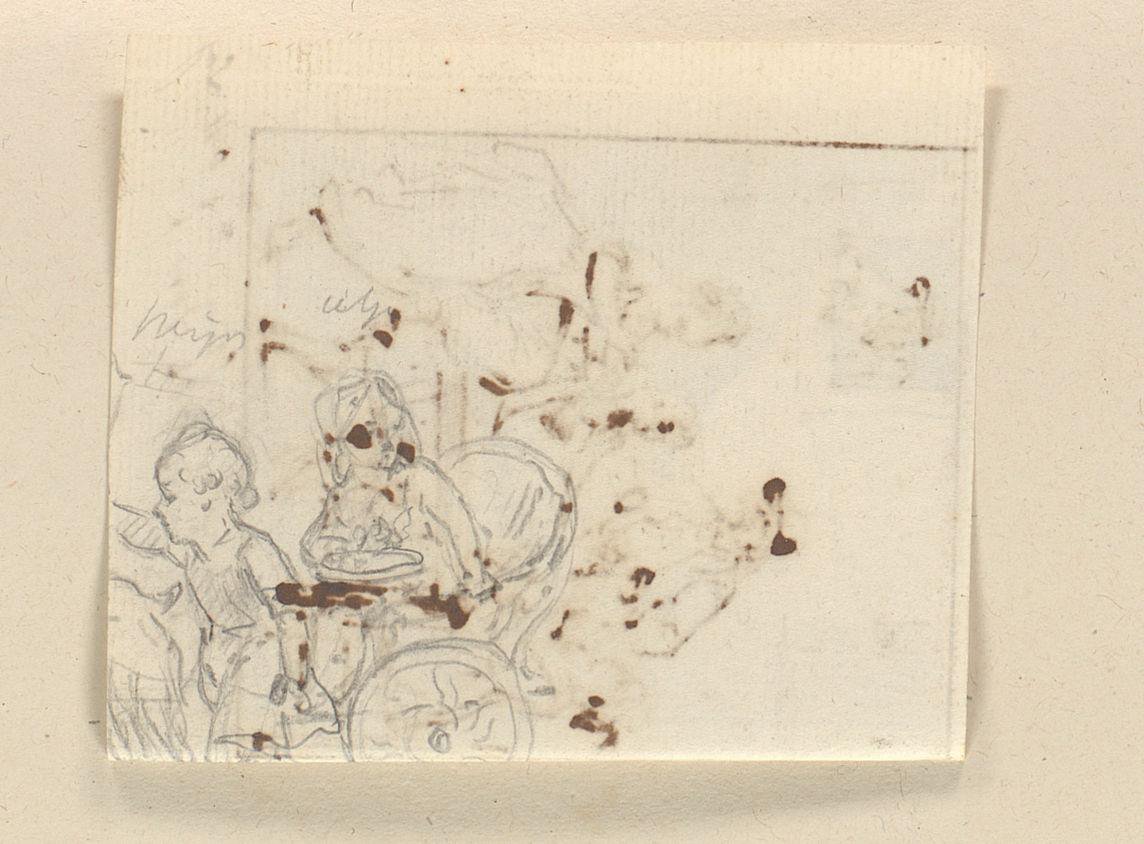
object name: album leaf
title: Schets van gezelschap of gezin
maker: jurriaan andriessen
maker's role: draughtsman, painter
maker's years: 1742-1819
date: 1782-1819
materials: paper, pencil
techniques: pasting